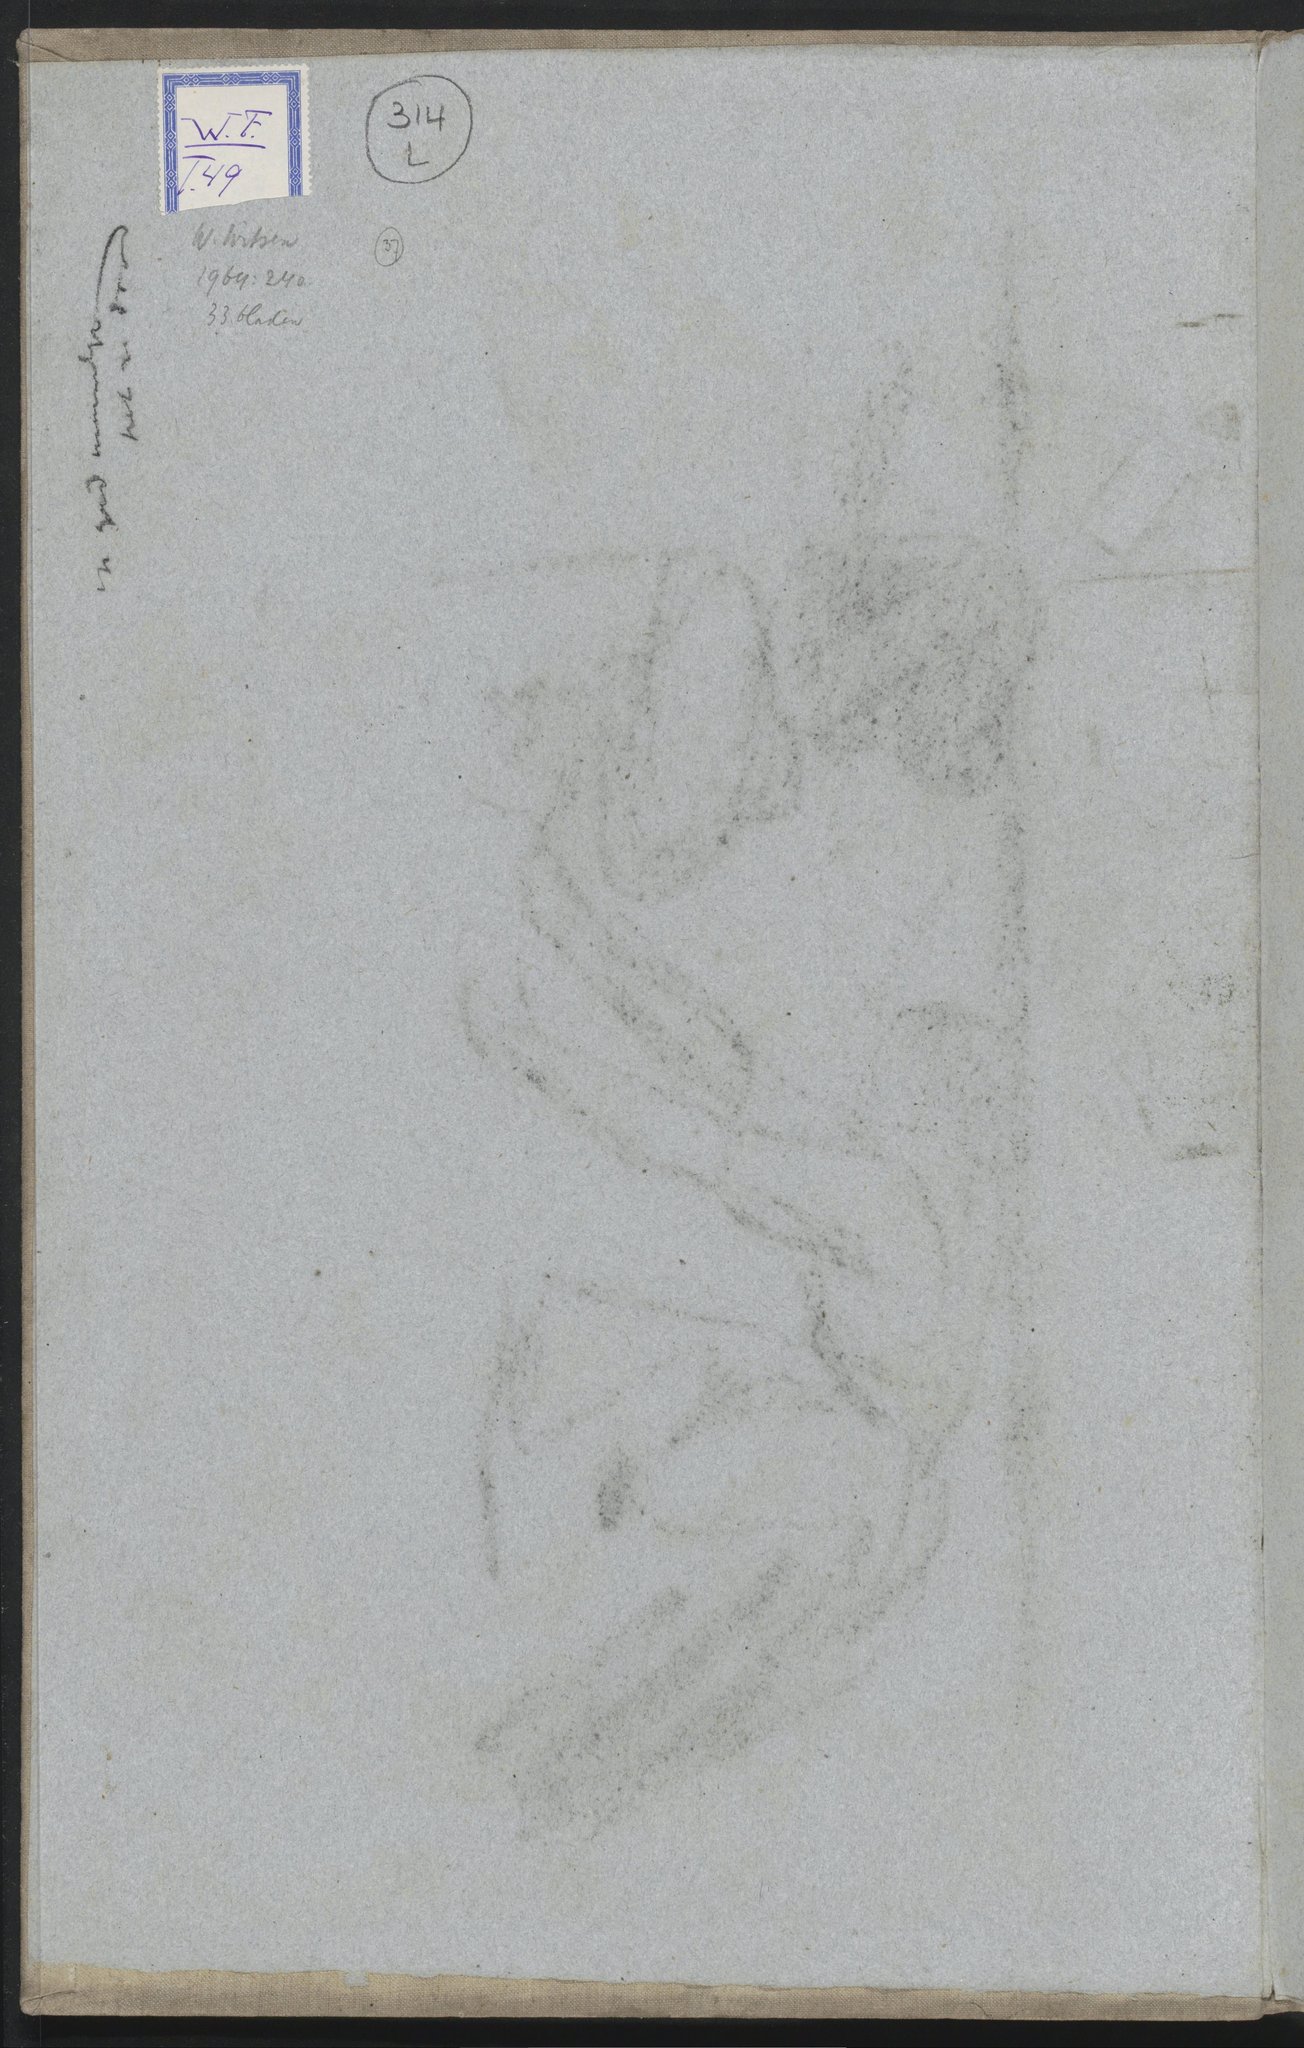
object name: sketchbook leaf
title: Annotaties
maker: willem witsen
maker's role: draughtsman, painter, print maker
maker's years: 1860-1923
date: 1886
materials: chalk, paper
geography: ewijkshoeve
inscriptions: annotation: ‘W.F./ T. 49/ [...]’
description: En een abklatsch van de krijttekening op pagina 1. Schutblad A, voorste schutblad, uit een schetsboek met 38 bladen betekend rond de Ewijkshoeve.